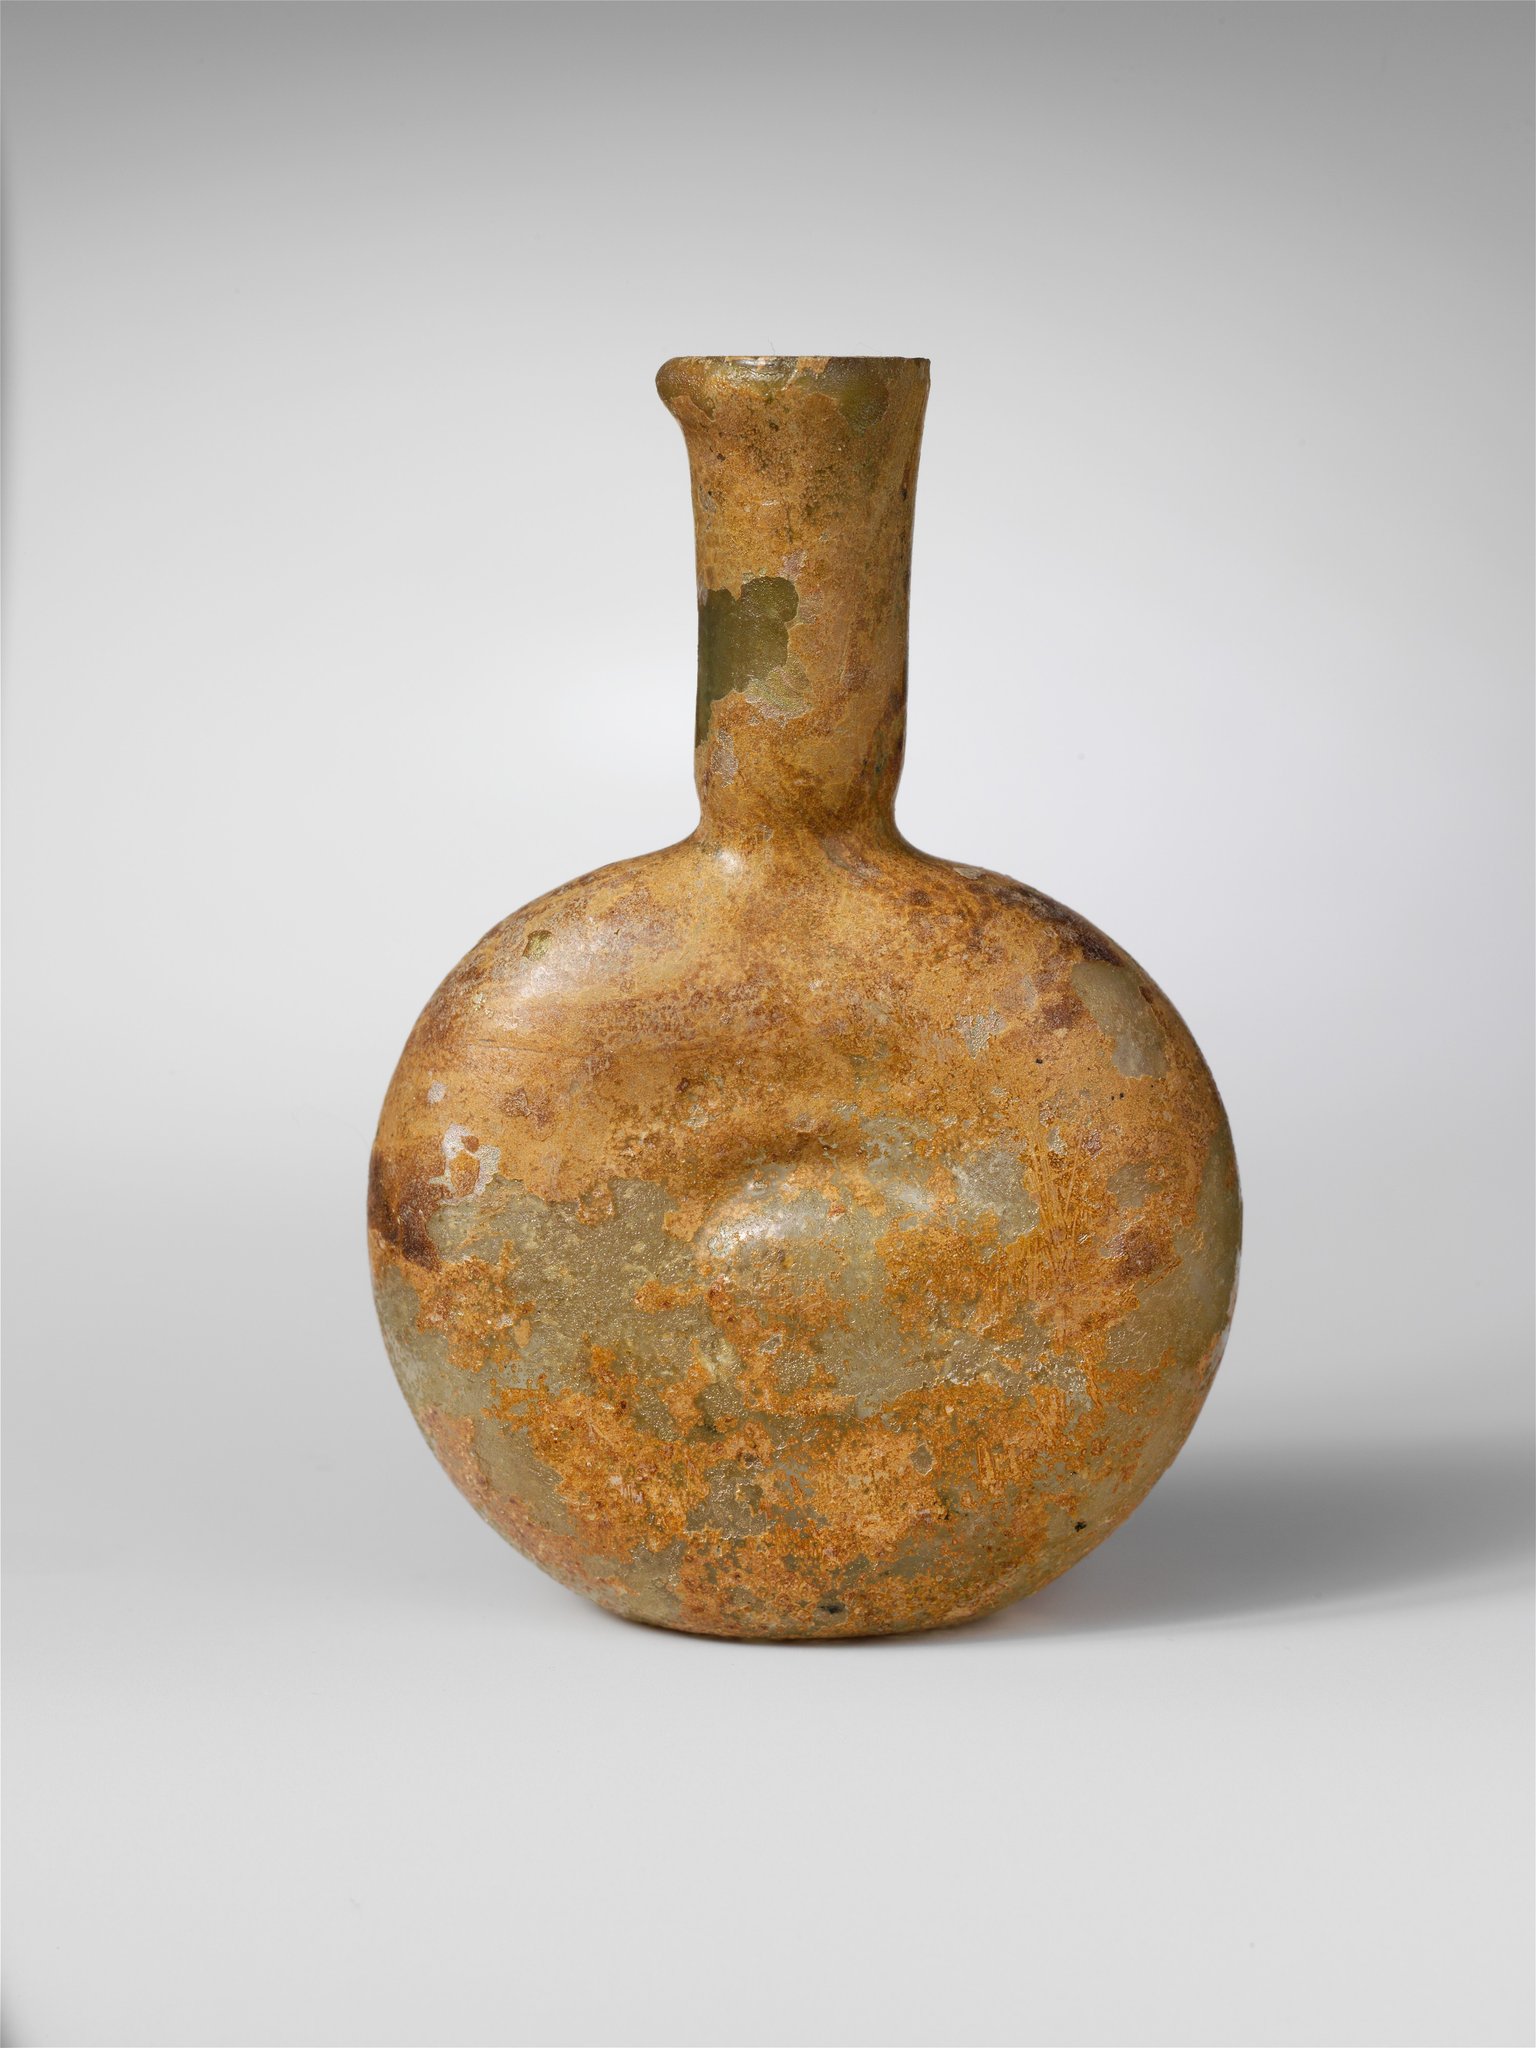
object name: bottle, lentoid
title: Glass lentoid bottle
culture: roman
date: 101-300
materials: glass